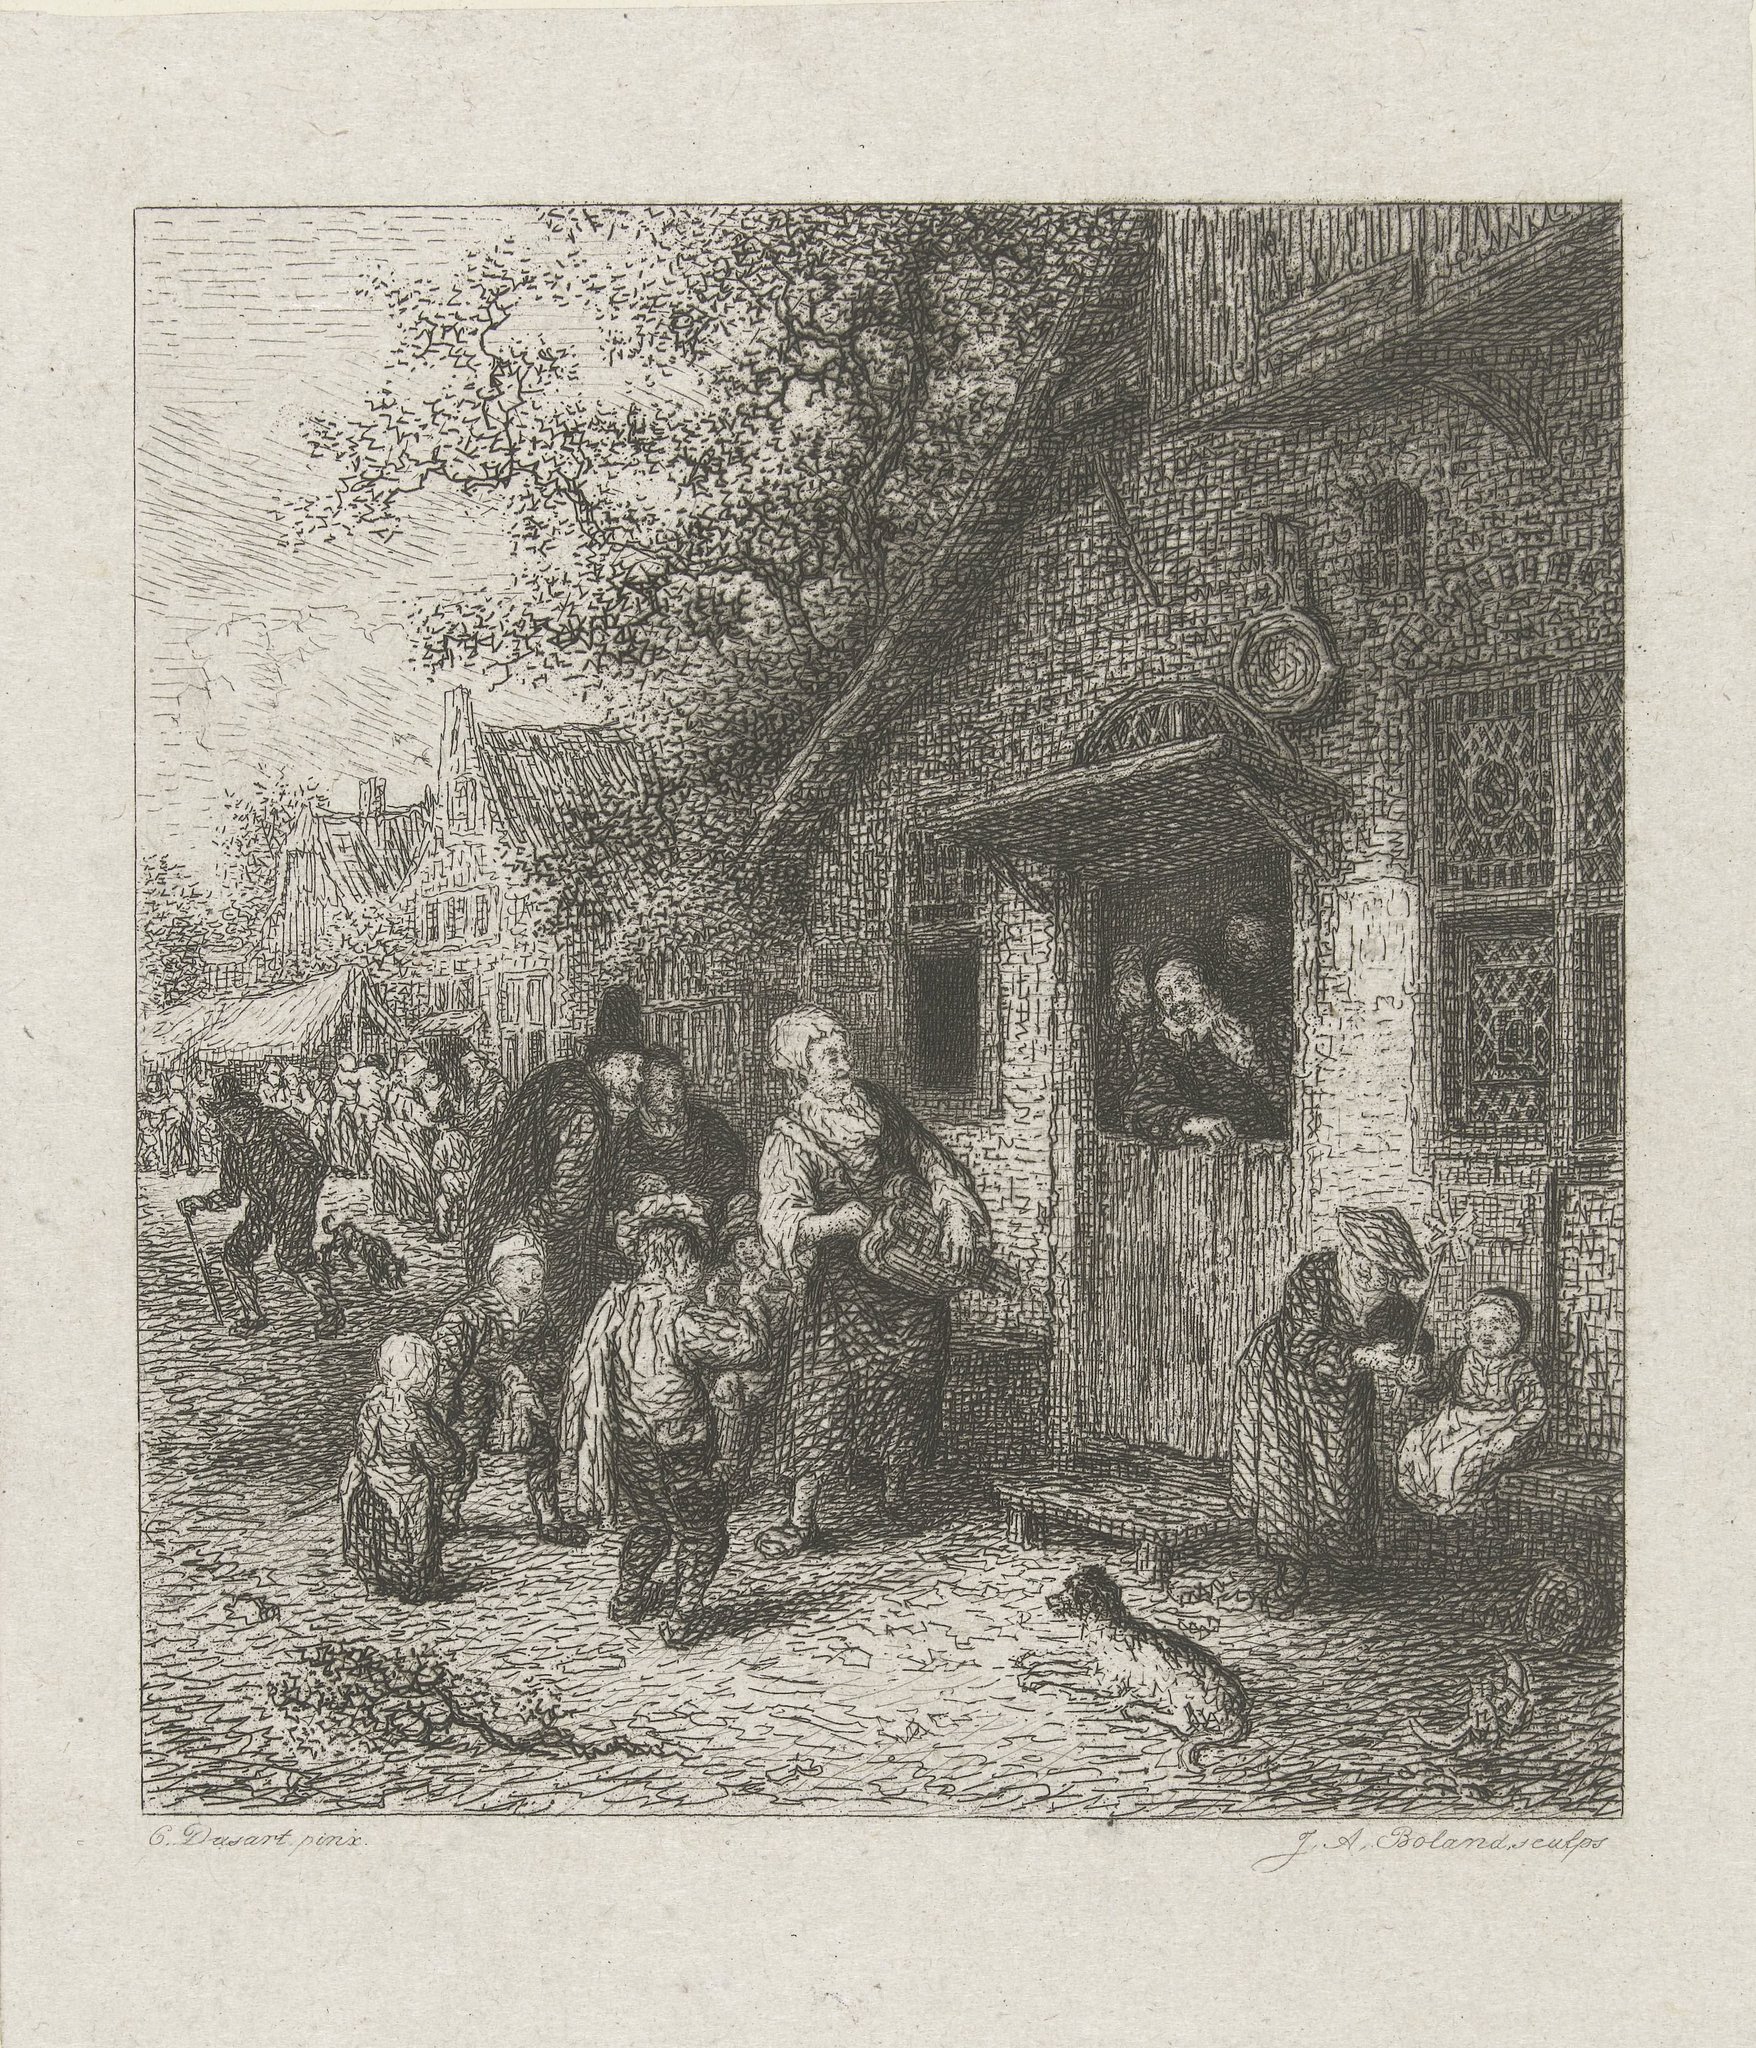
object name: print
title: Boerenkermis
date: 1875-1876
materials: paper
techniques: etching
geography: amsterdam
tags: 'fahrende leute', vagrants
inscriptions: collector's mark: Lugt 2228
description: Reproductie van een schilderij uit de collectie van het Rijksmuseum Amsterdam, SK-A-99. Prent afkomstig uit: Brink, J. ten (et al.). Het Rijksmuseum te Amsterdam: [25] etsen van J.A. Boland. Haarlem: J.M. Schalekamp, [1875-1876] (13 A 20).